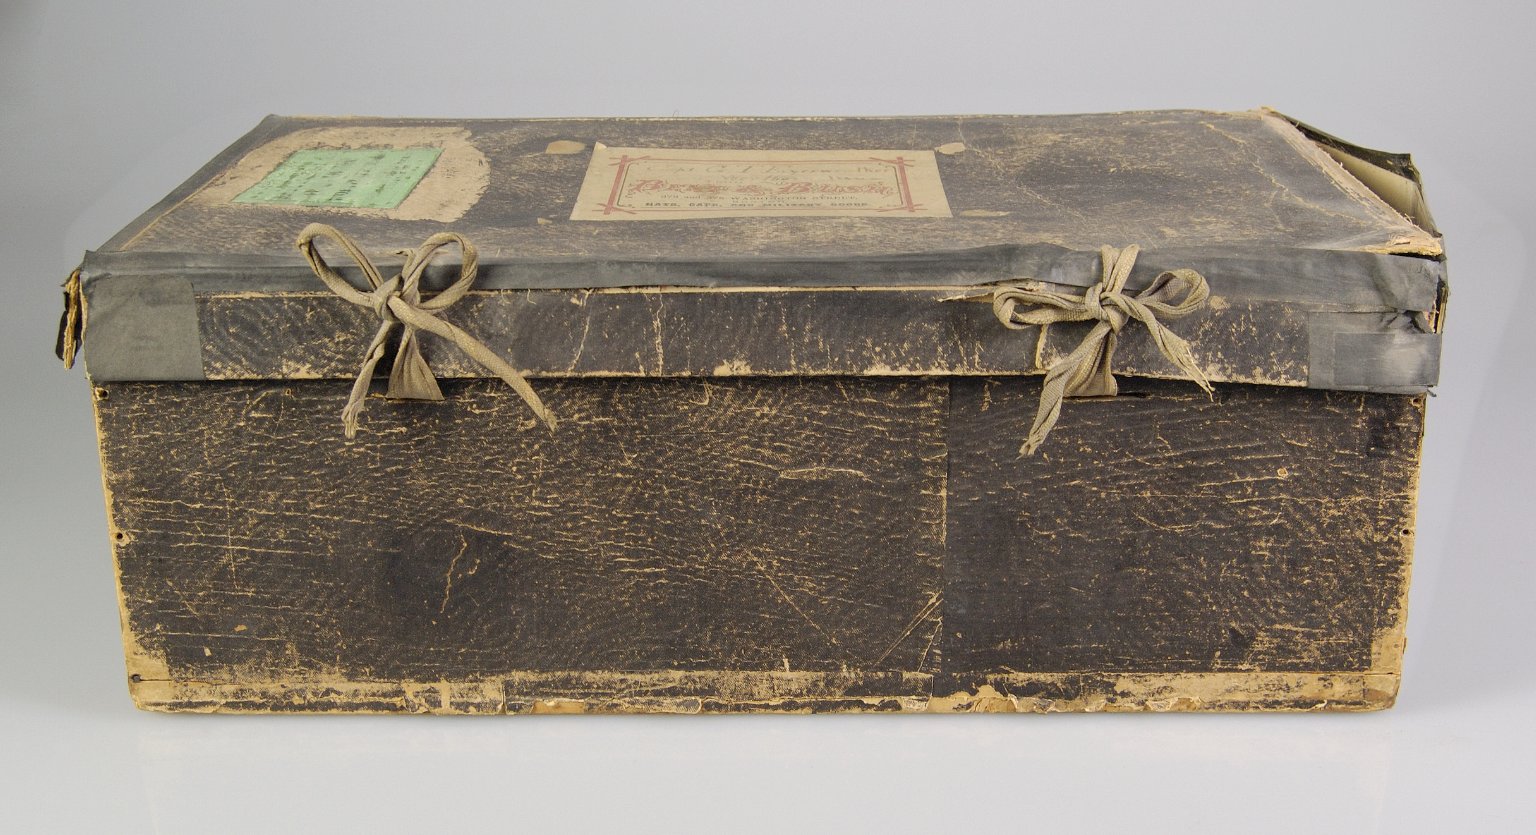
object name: military hatbox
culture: american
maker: bent & bush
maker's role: designer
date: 1864-1880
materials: cotton, metal, paper, wood